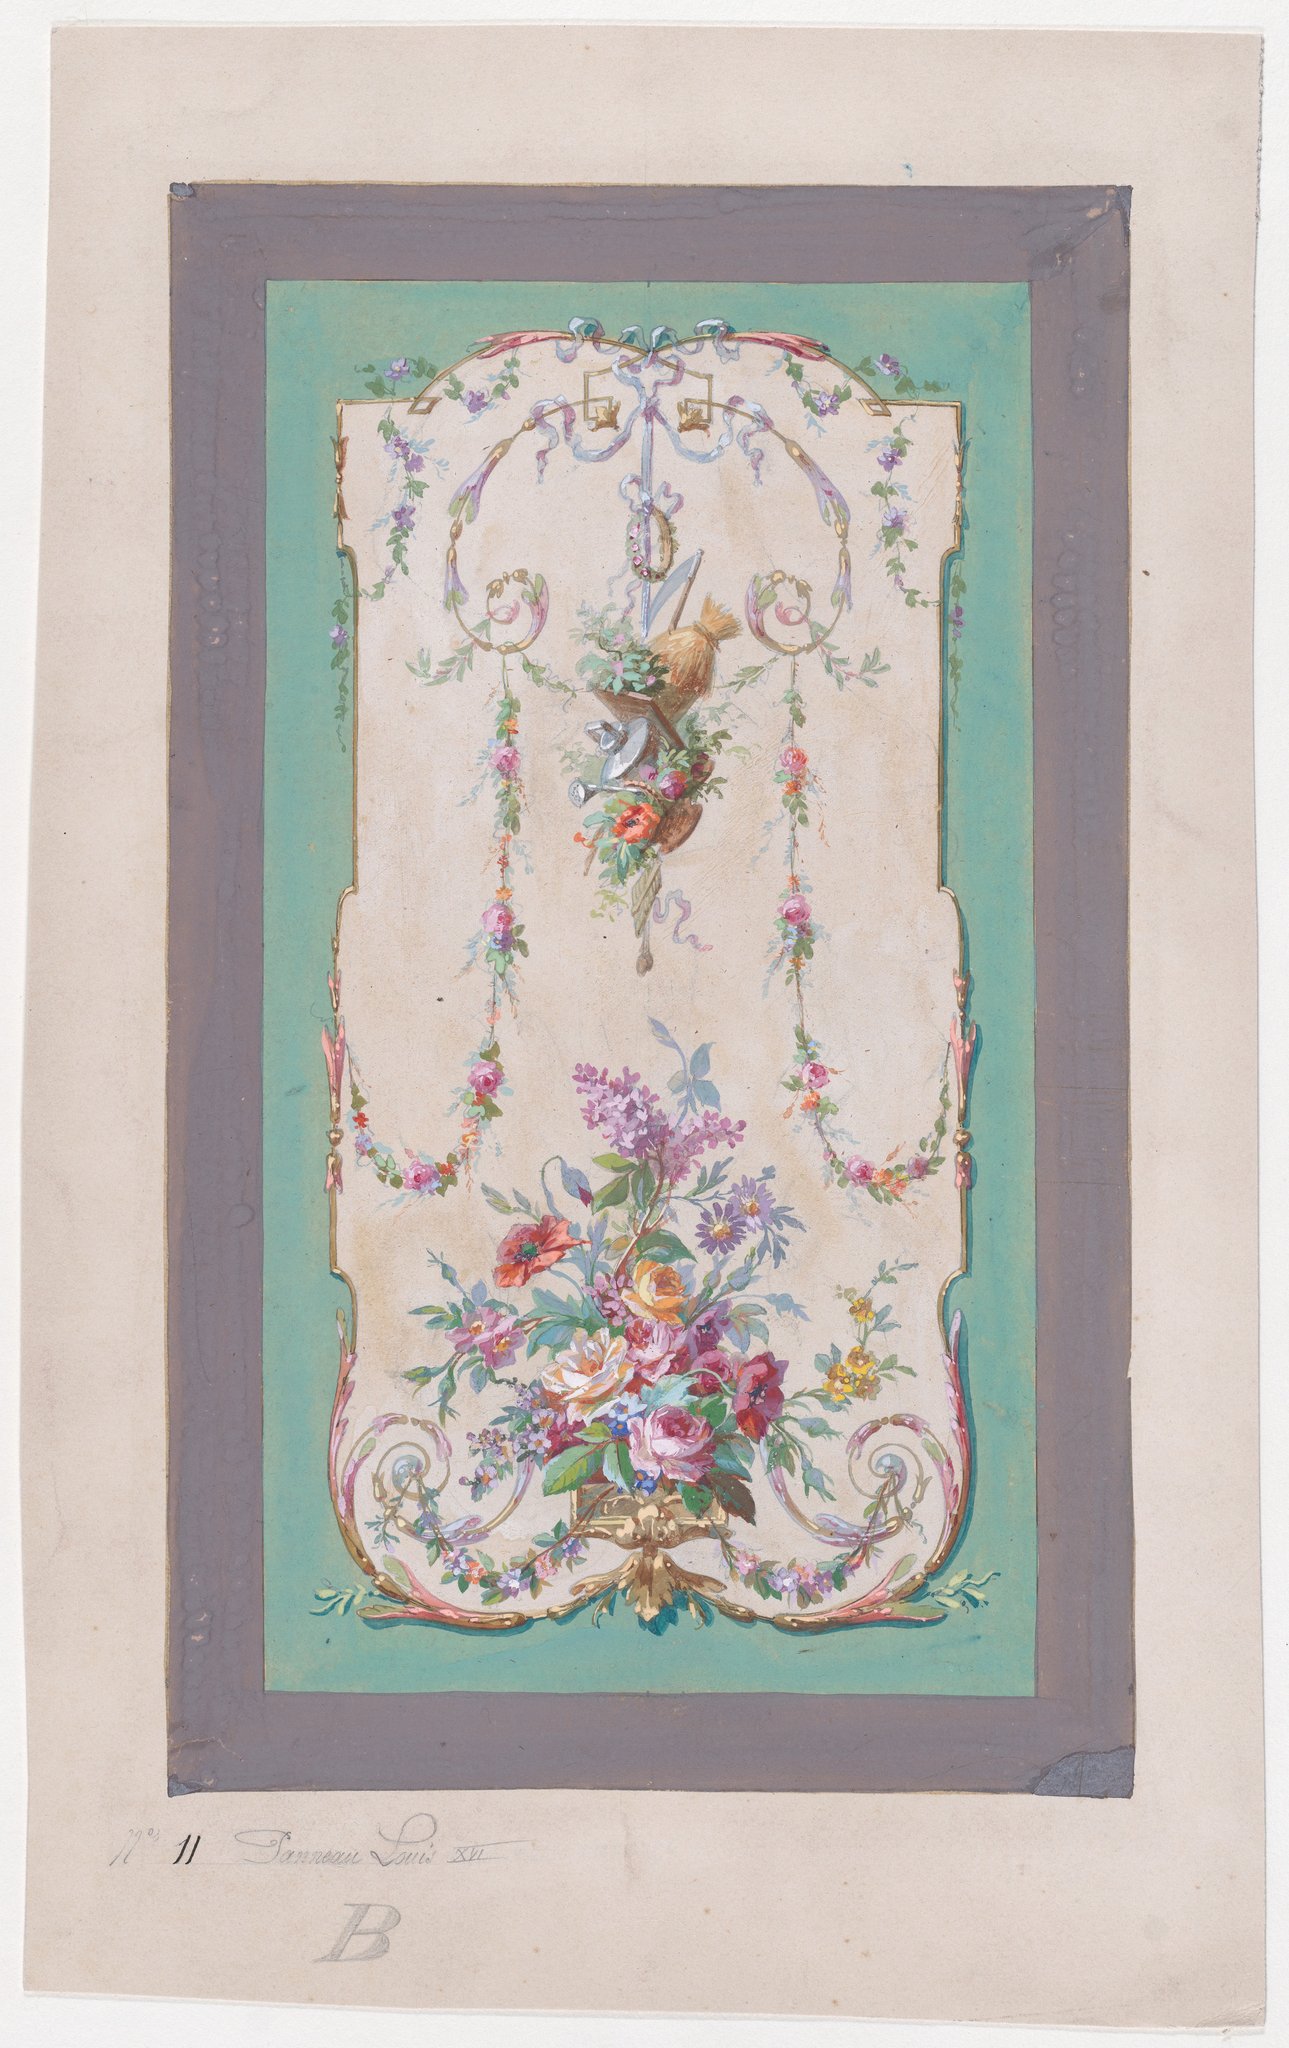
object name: drawing ornament architecture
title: Design for a Panel with a Large Bundle of Flowers and Leaves and a Hanging Thin Bundle Containing Gardening Tools Inside an Ornamental Frame Decorated with Thin Garlands of Flowers and Leaves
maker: anonymous, french, 19th century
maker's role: designer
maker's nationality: french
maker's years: 1800-1900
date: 1870-1900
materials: gouache, watercolor